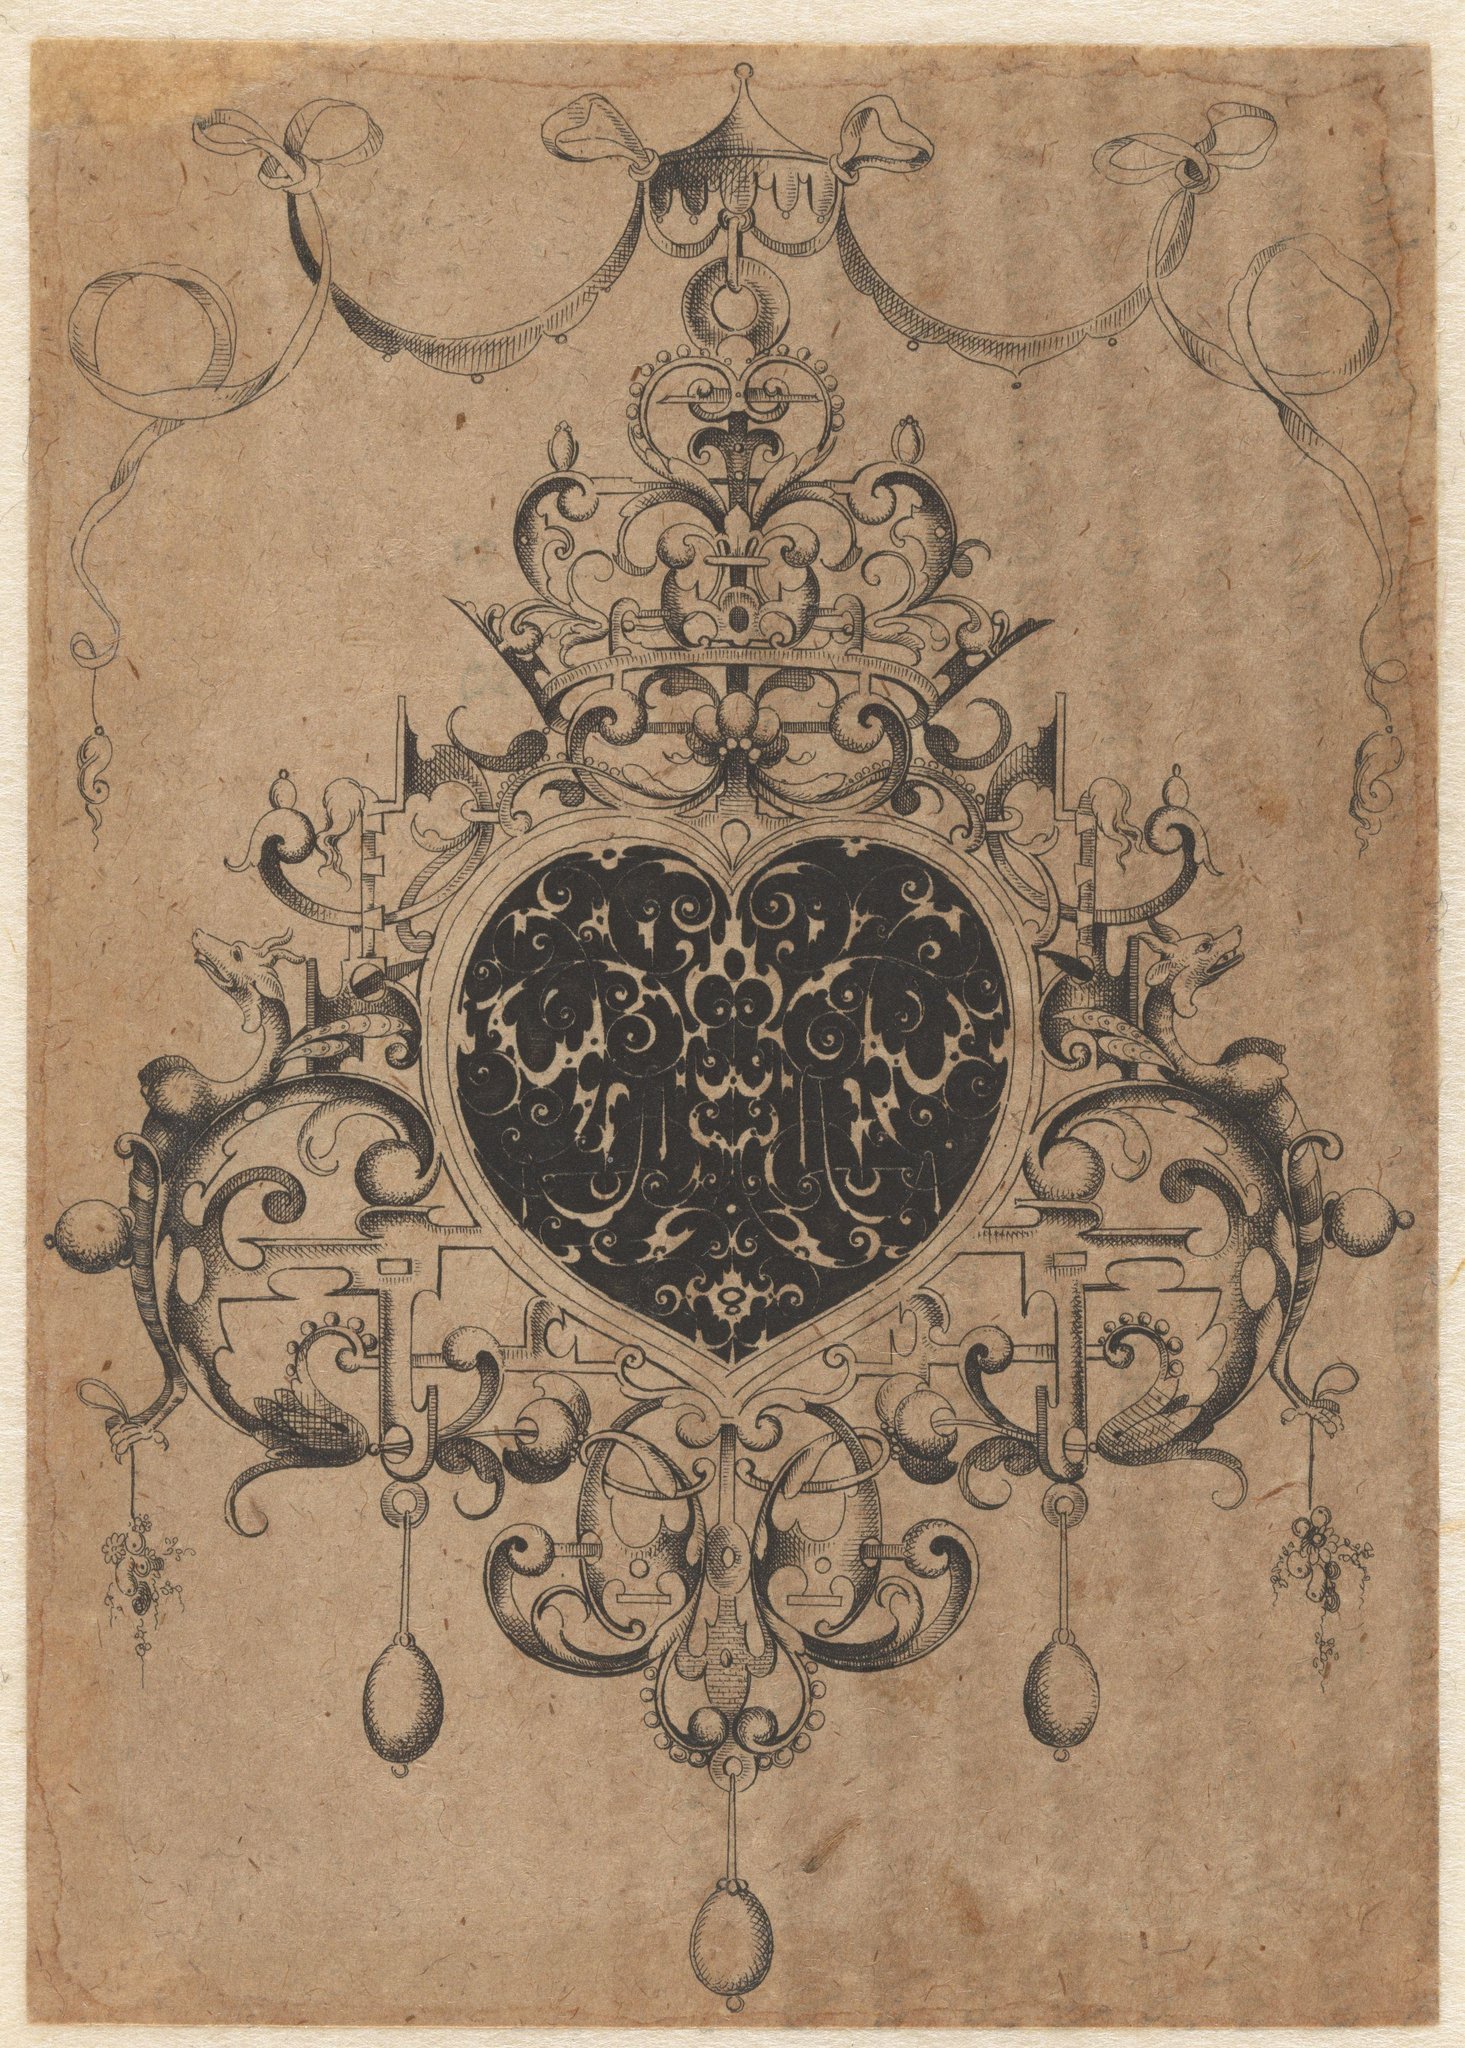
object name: ornament print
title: Ornamentele hanger met hartvorm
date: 1609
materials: paper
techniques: engraving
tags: ornaments ~ art, pendant, trinket, 'breloque'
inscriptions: :, collector's mark: Lugt 2228, collector's mark: Lugt 2760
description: Ontwerp voor hanger bestaande uit ranken met centraal een gekroond hart. Zwartornament.